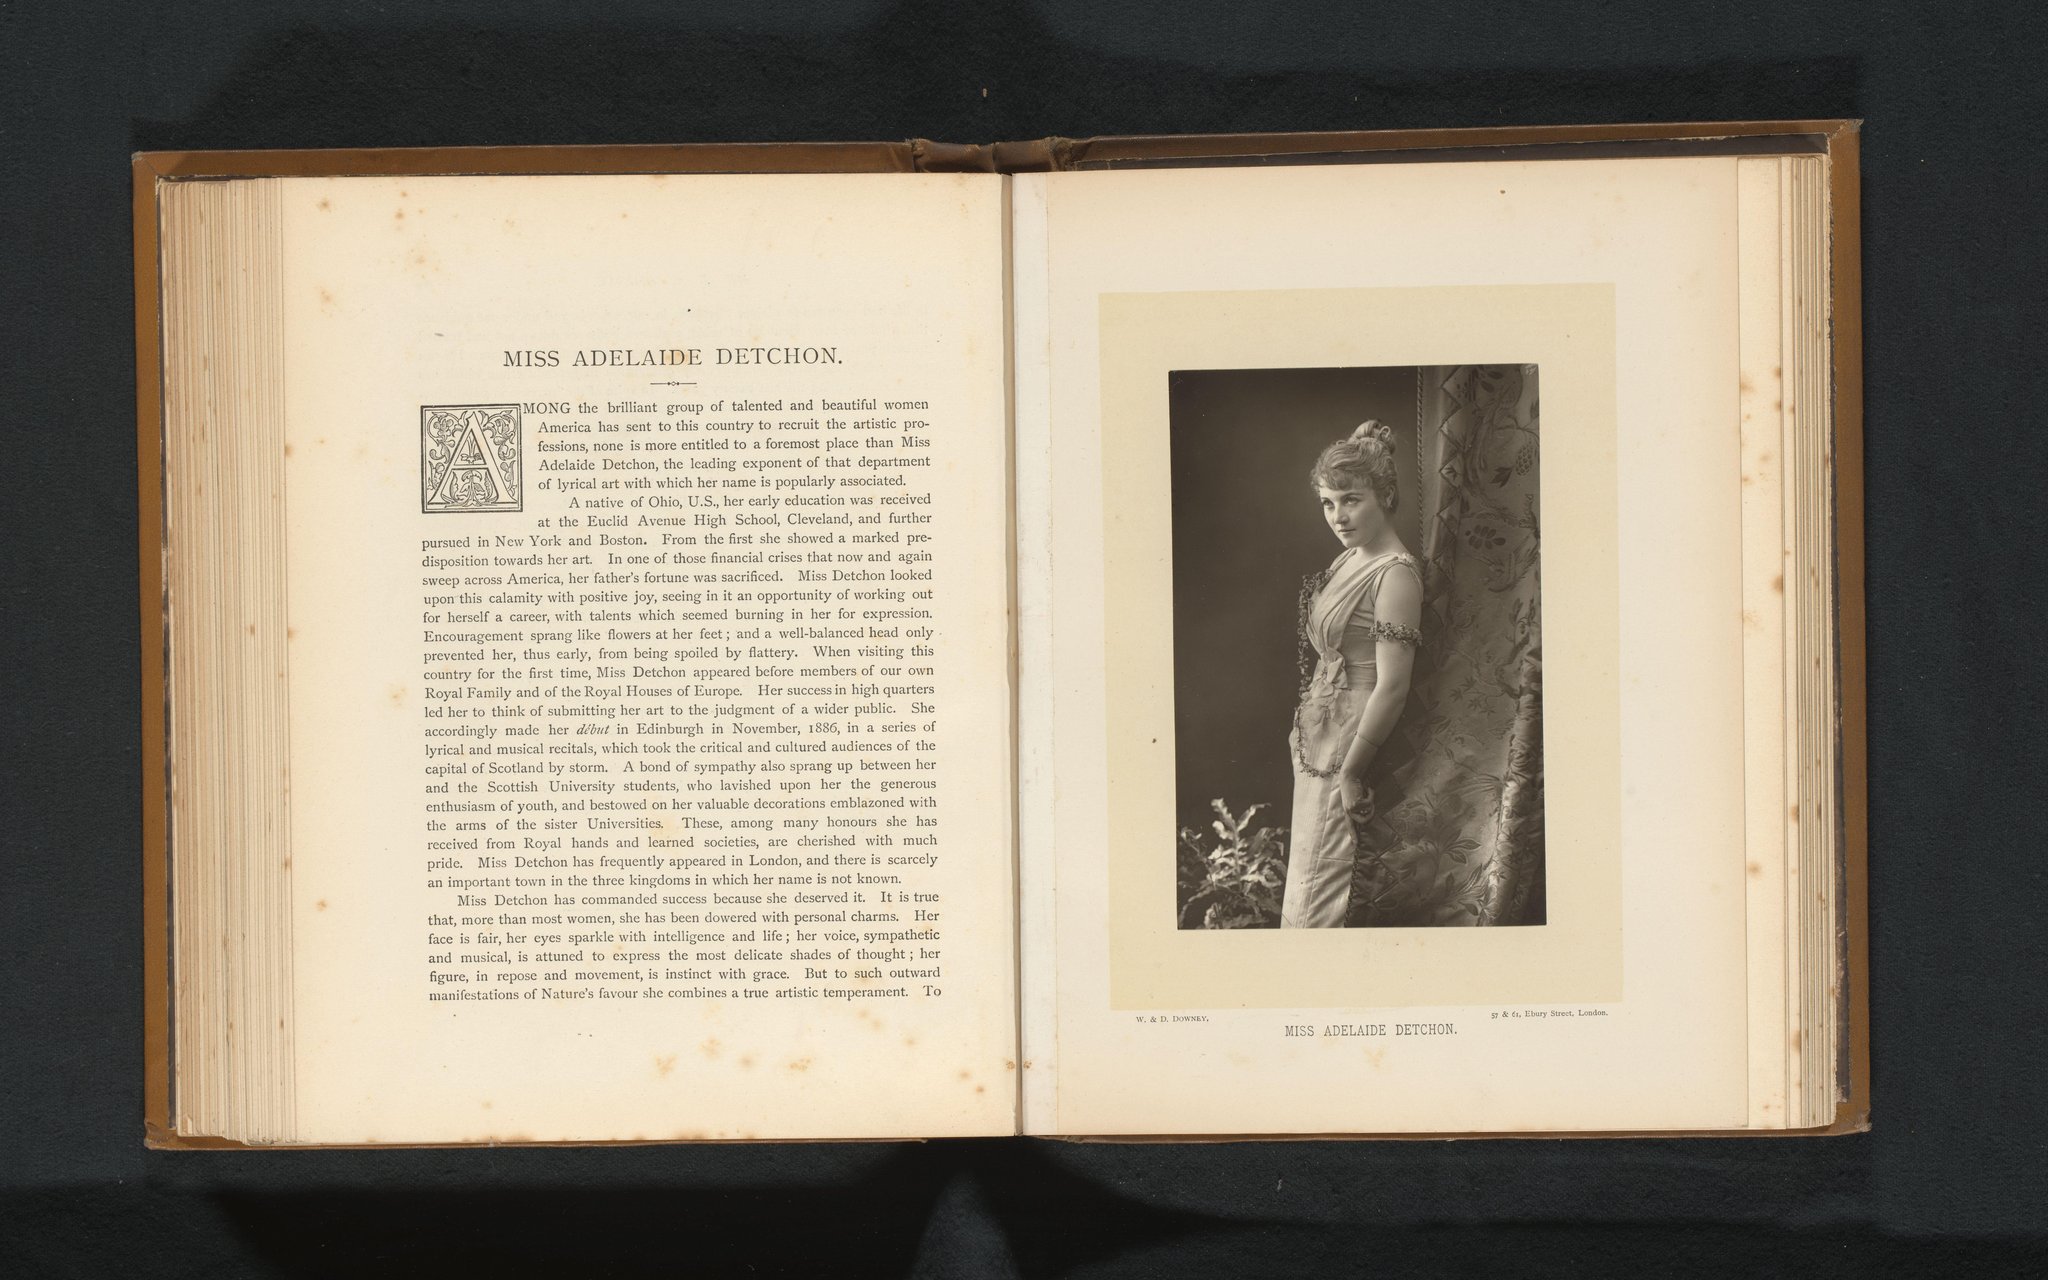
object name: page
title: Portret van Adelaide Detchon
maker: Anonymous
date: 1882-1892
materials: paper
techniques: woodburytype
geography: london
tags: portrait of actor, actress, female singer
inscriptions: inscription: ‘57 & 61, Elbury Street, London.’